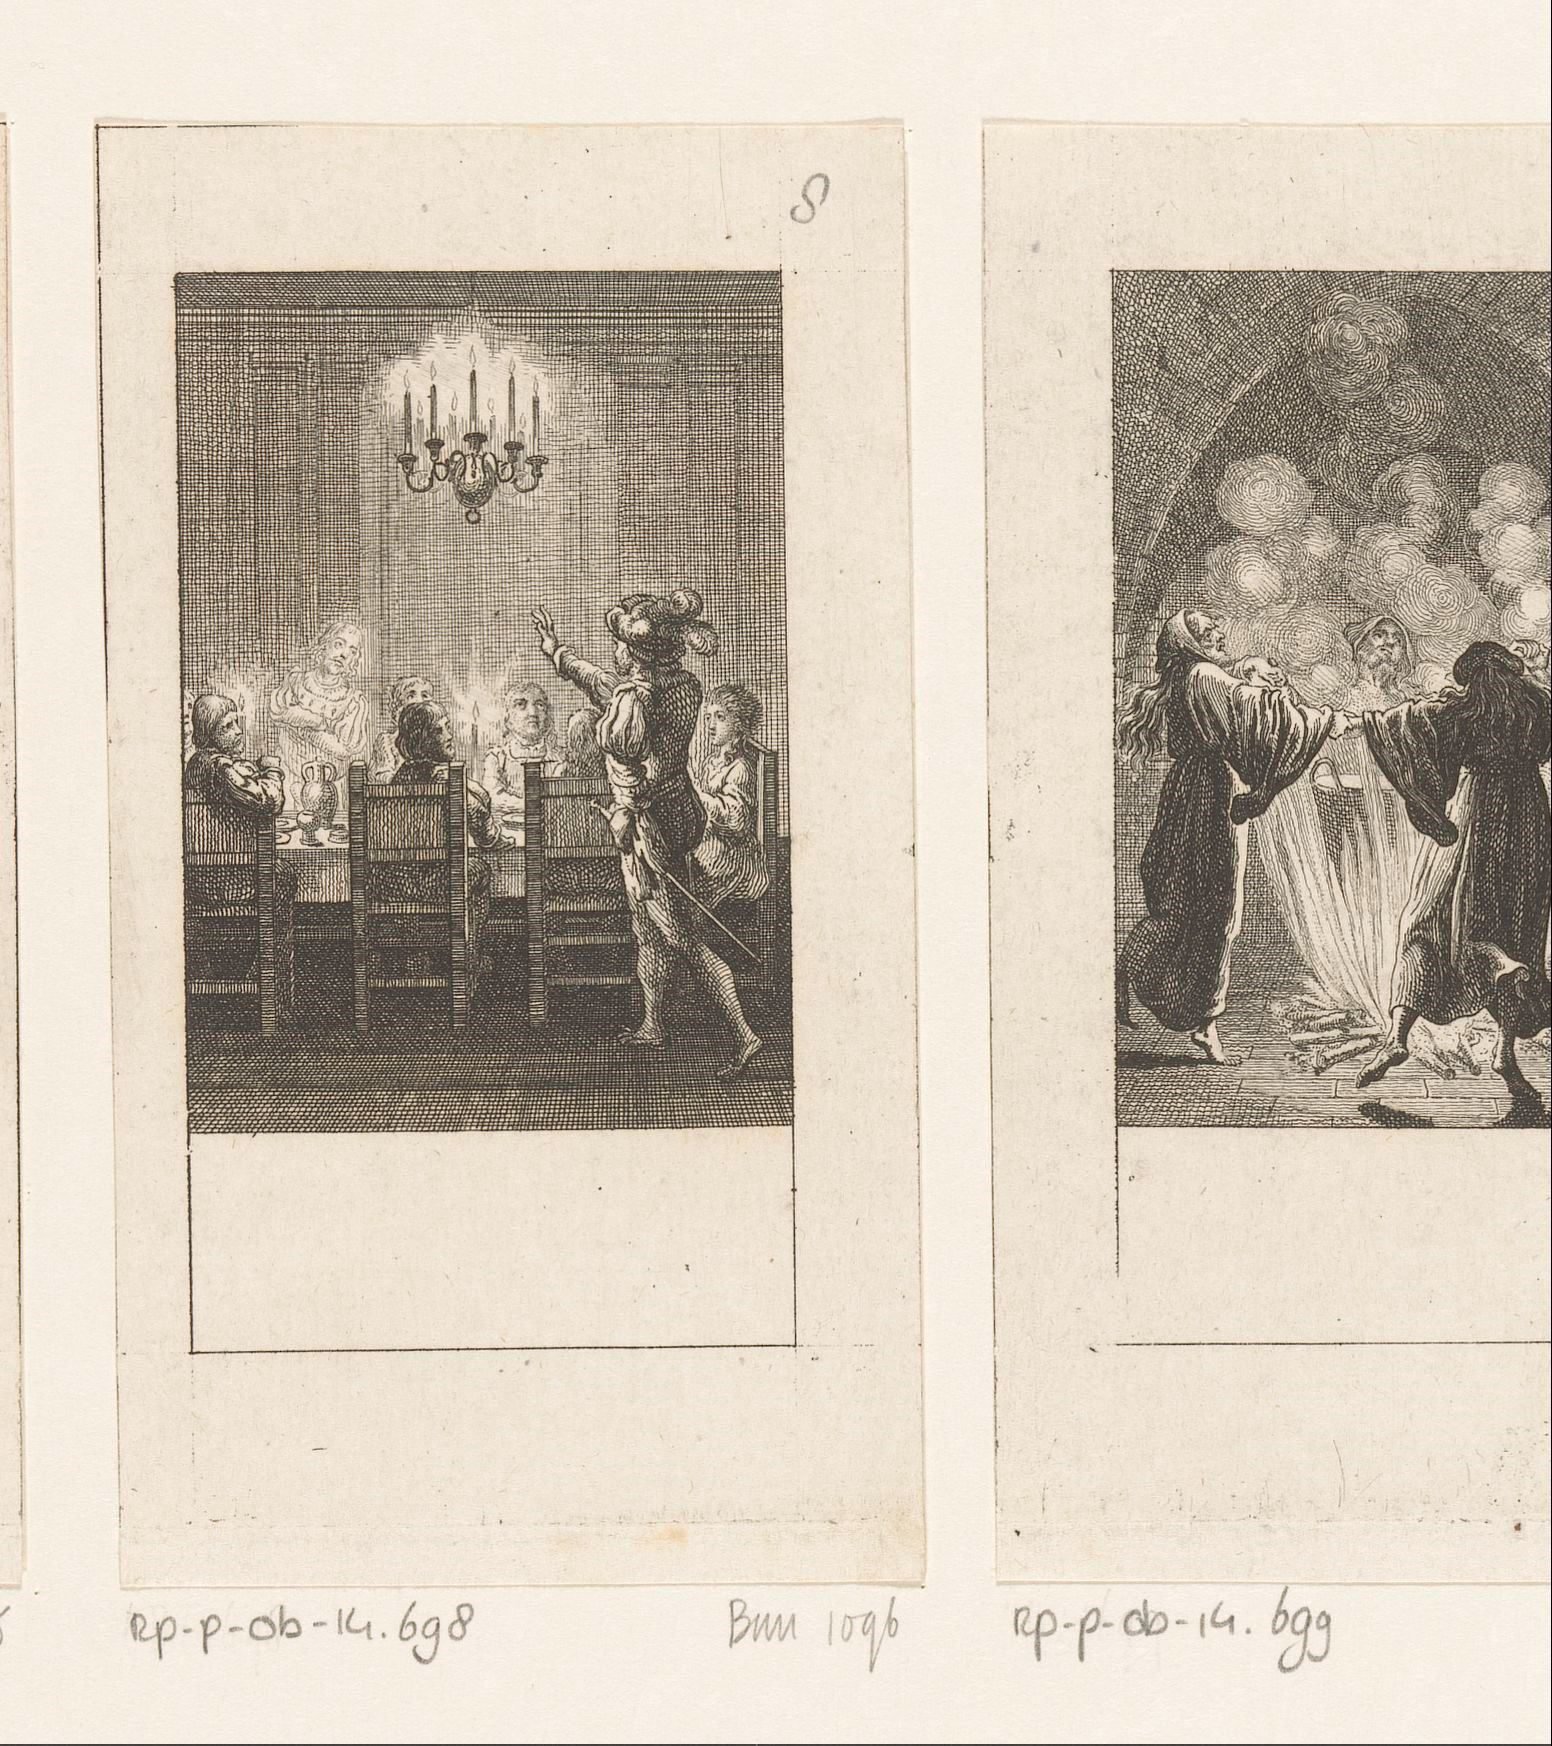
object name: print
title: Macbeth ziet de geest van Banquo tijdens het feestmaal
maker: daniel nikolaus chodowiecki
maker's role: draughtsman, print maker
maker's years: 1726-1801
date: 1784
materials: paper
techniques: etching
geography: berlin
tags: william shakespeare, literature, spirit, ghost, celebration meal, feast, banquet, macbeth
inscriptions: collector's mark: Lugt 2228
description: Vervaardigd voor William Shakespeares 'Macbeth'. Latere staat gebruikt voor: Goettinger Taschen Calender vom Jahre 1785. Göttingen: Johann Christoph Dietrich, 1784.